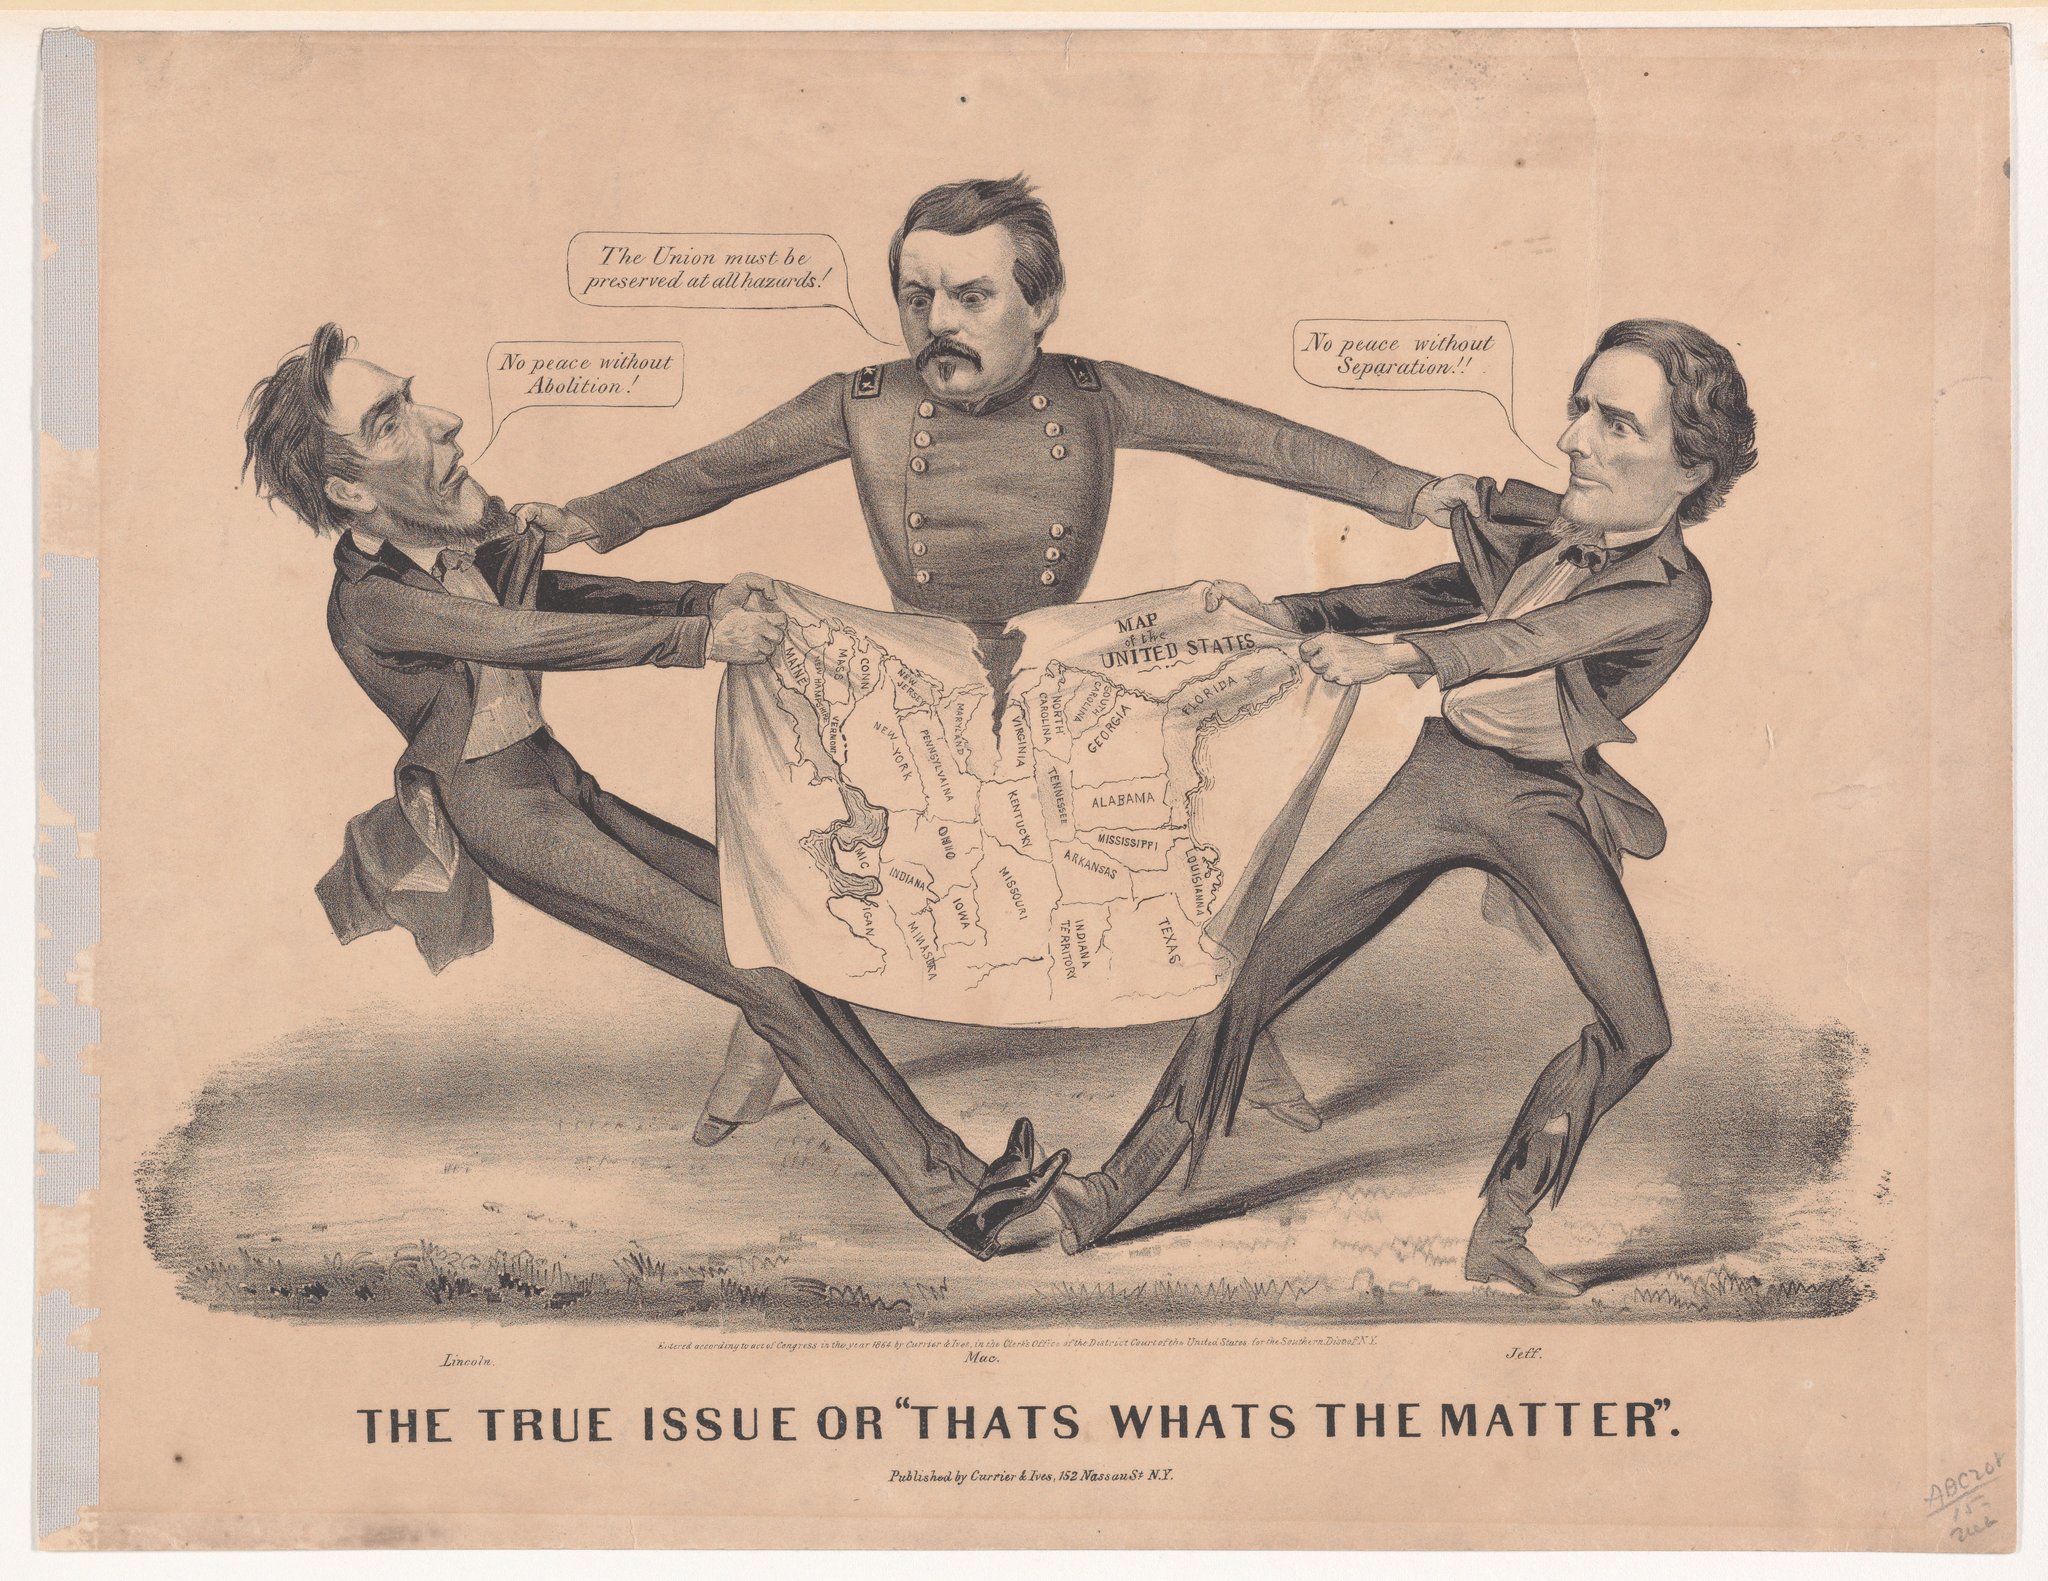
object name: print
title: The True Issue or "Thats Whats the Matter"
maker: currier & ives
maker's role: publisher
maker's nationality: american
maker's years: 1857-1907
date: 1864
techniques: lithograph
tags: satire,american civil war,abraham lincoln,politics